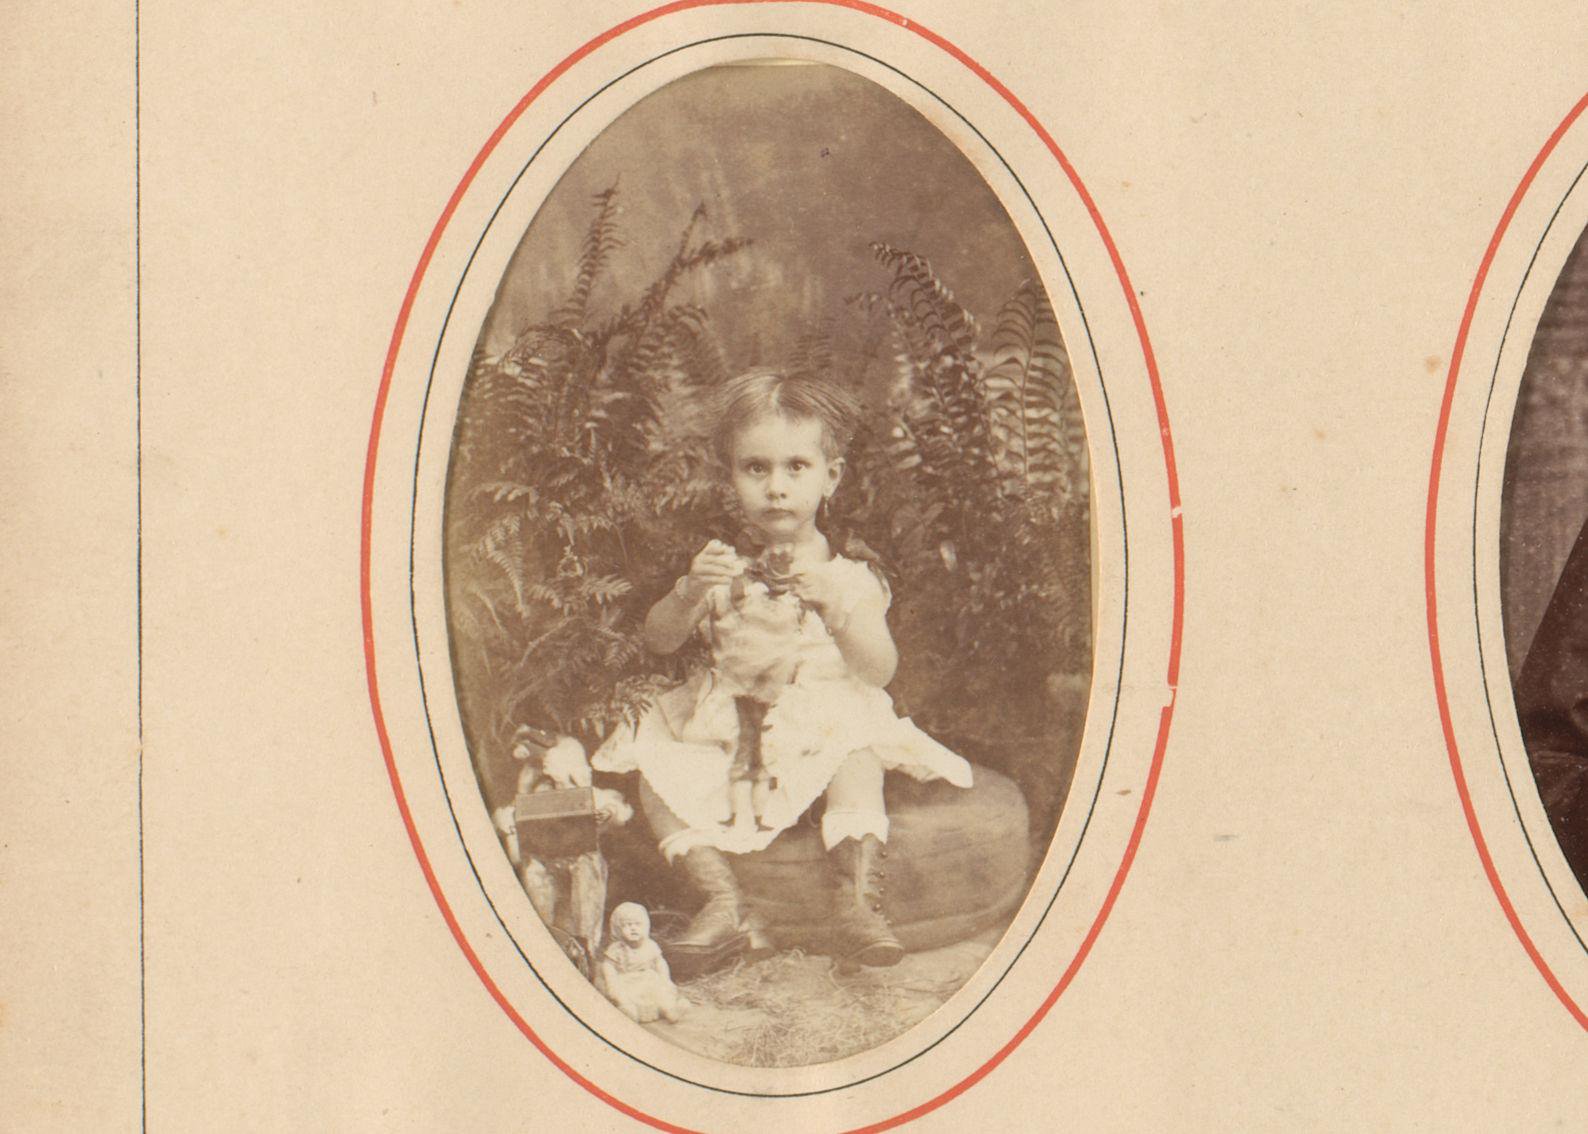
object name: photograph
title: Portret van een onbekend meisje met pop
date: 1870-1890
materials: cardboard, paper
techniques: albumen print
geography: batavia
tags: anonymous historical person portrayed - bb - woman